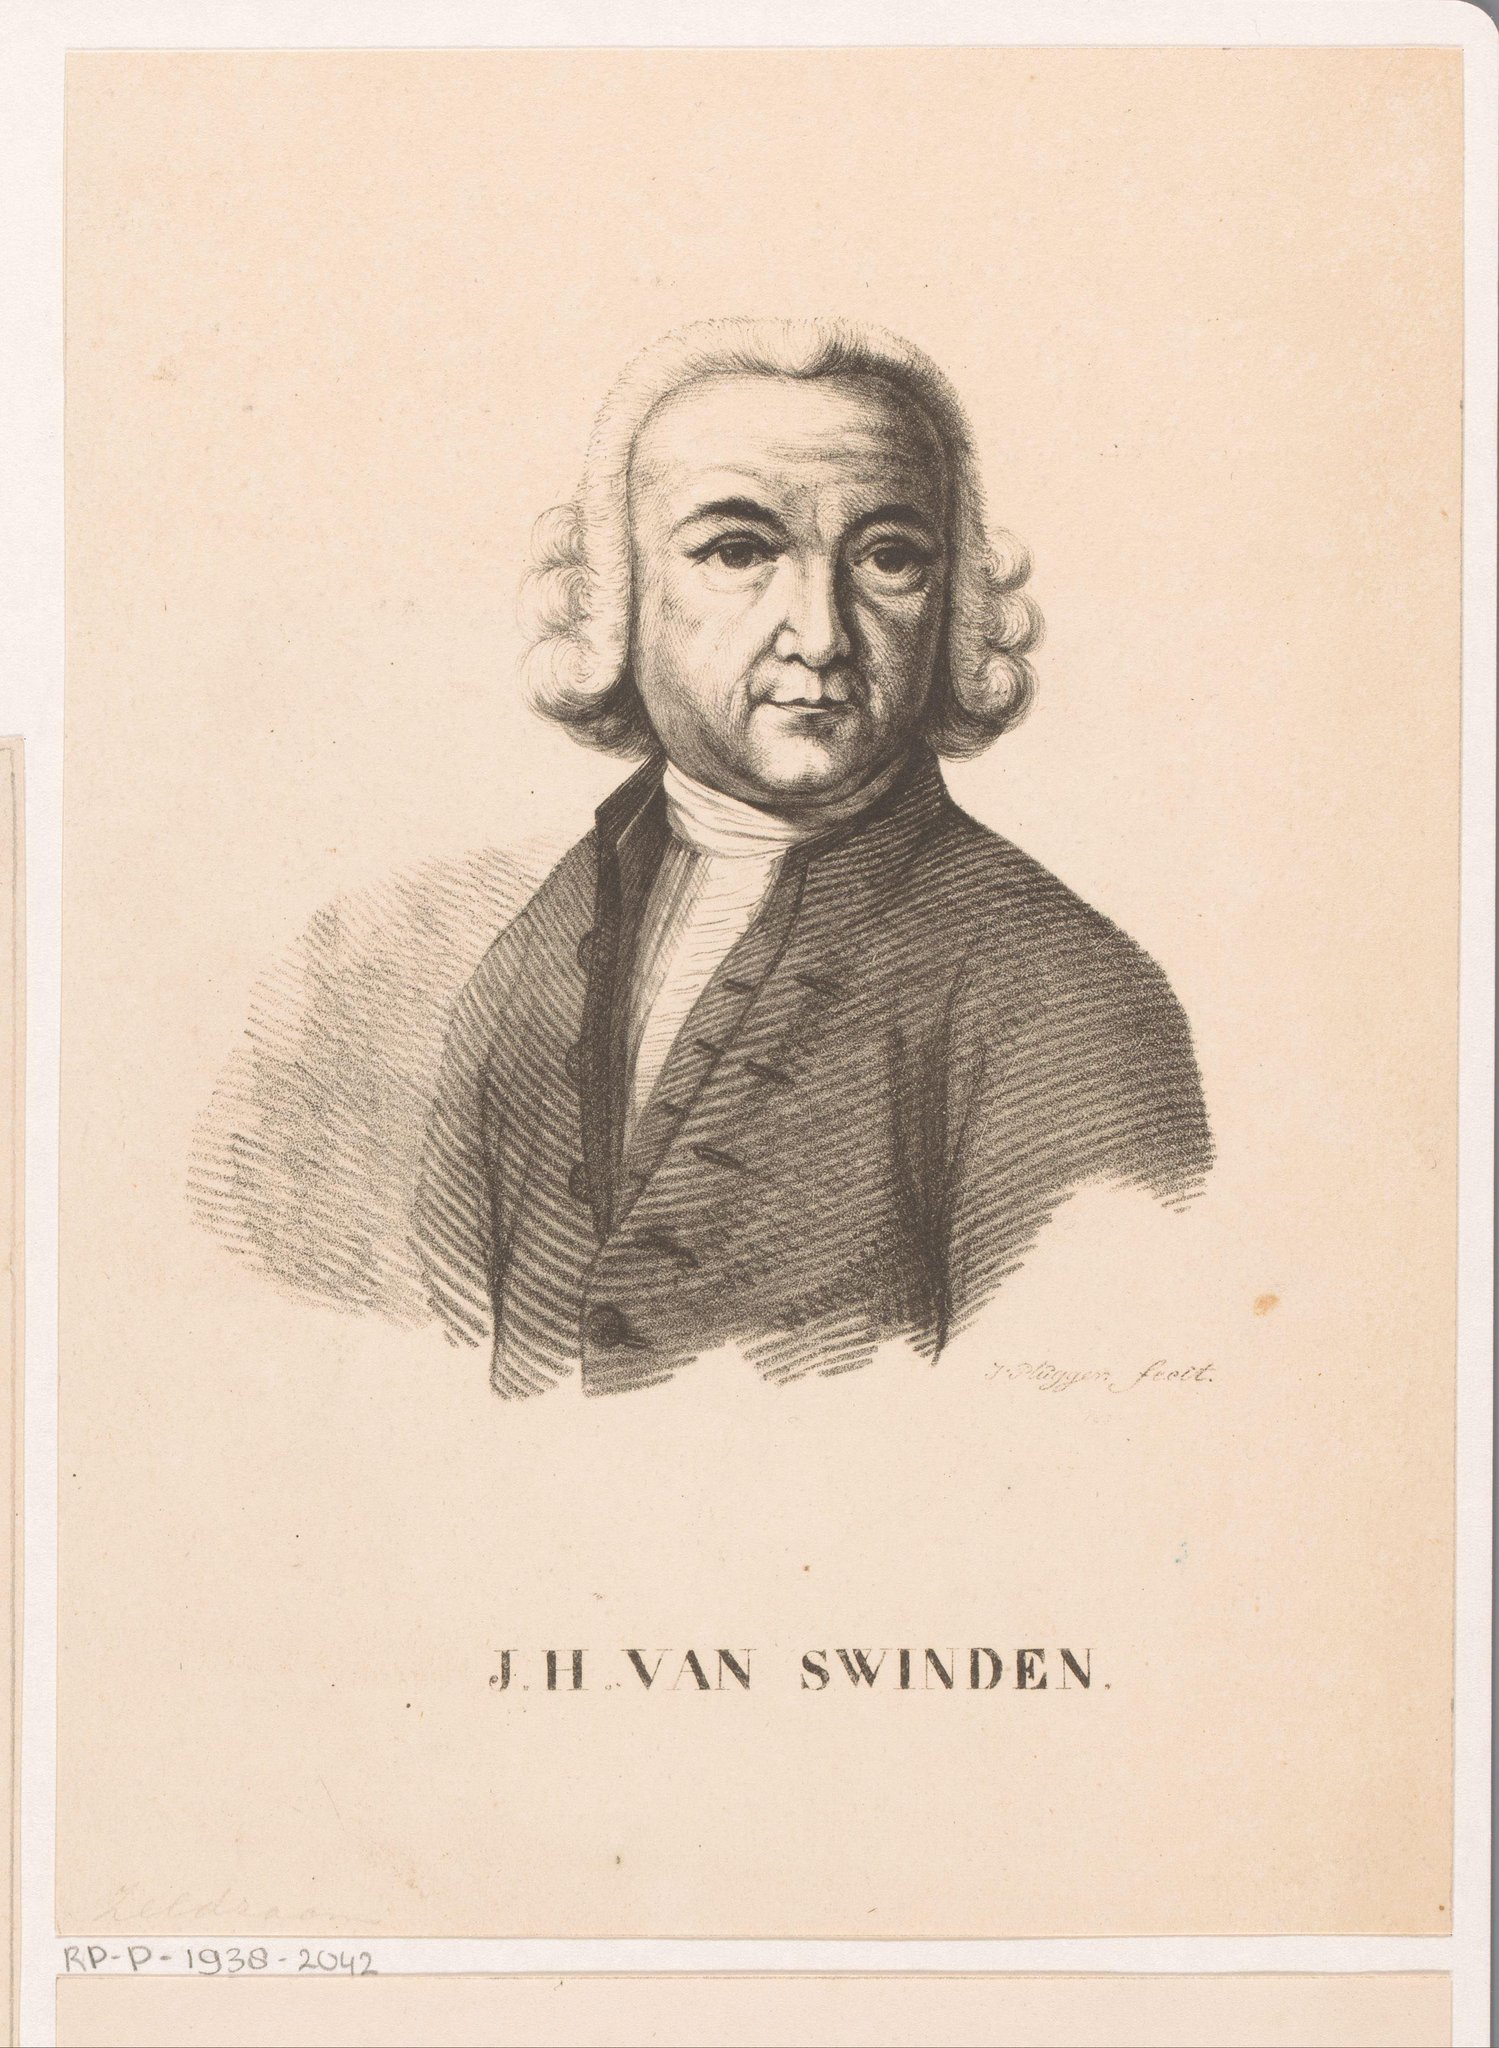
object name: print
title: J.H. van Swinden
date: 1822-1853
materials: paper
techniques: lithograph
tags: the hague, amsterdam, physicist, jean henri van swinden, historical persons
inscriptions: collector's mark: Lugt 2228, collector's mark: Lugt 2760